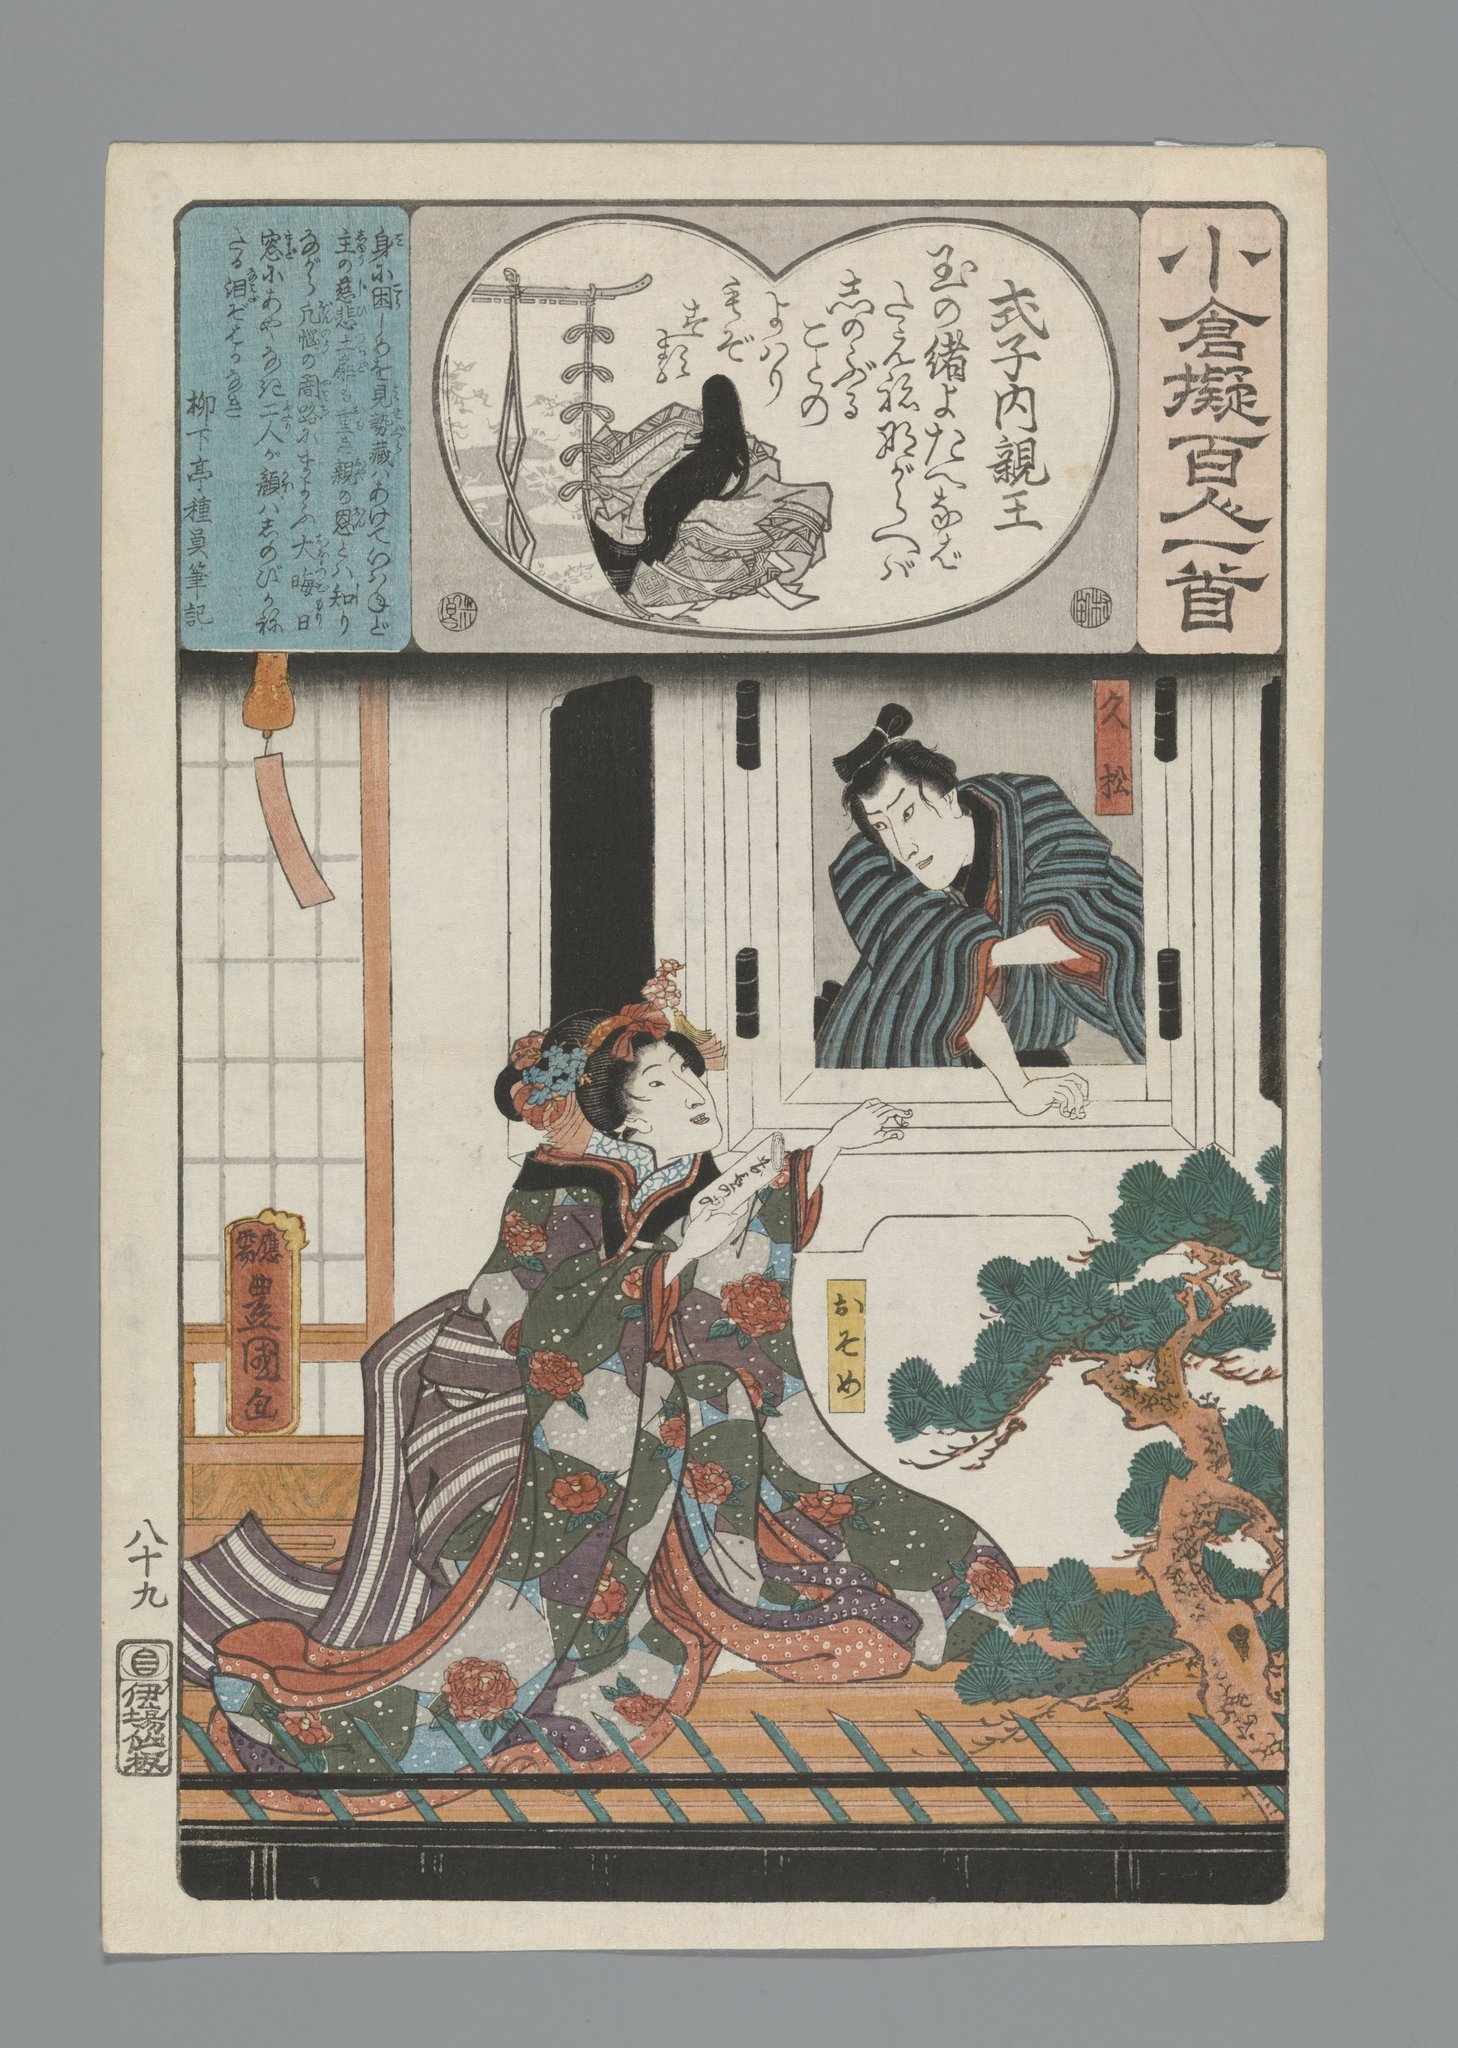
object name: print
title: Ogura Imitation of the One Hundred Poems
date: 1847-1850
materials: paper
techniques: woodcut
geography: japan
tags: group of actors, troupe; actors on the stage, human figure at (open) window, seen from outside - aa - feigned window, taking leave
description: Hisamatsu kijkt vanuit het raam naar zijn geliefde Osome, zittend op de veranda met hun afscheidsbrief in haar hand. Scene uit een kabukitoneelstuk. Gedicht door prinses Shokushi.